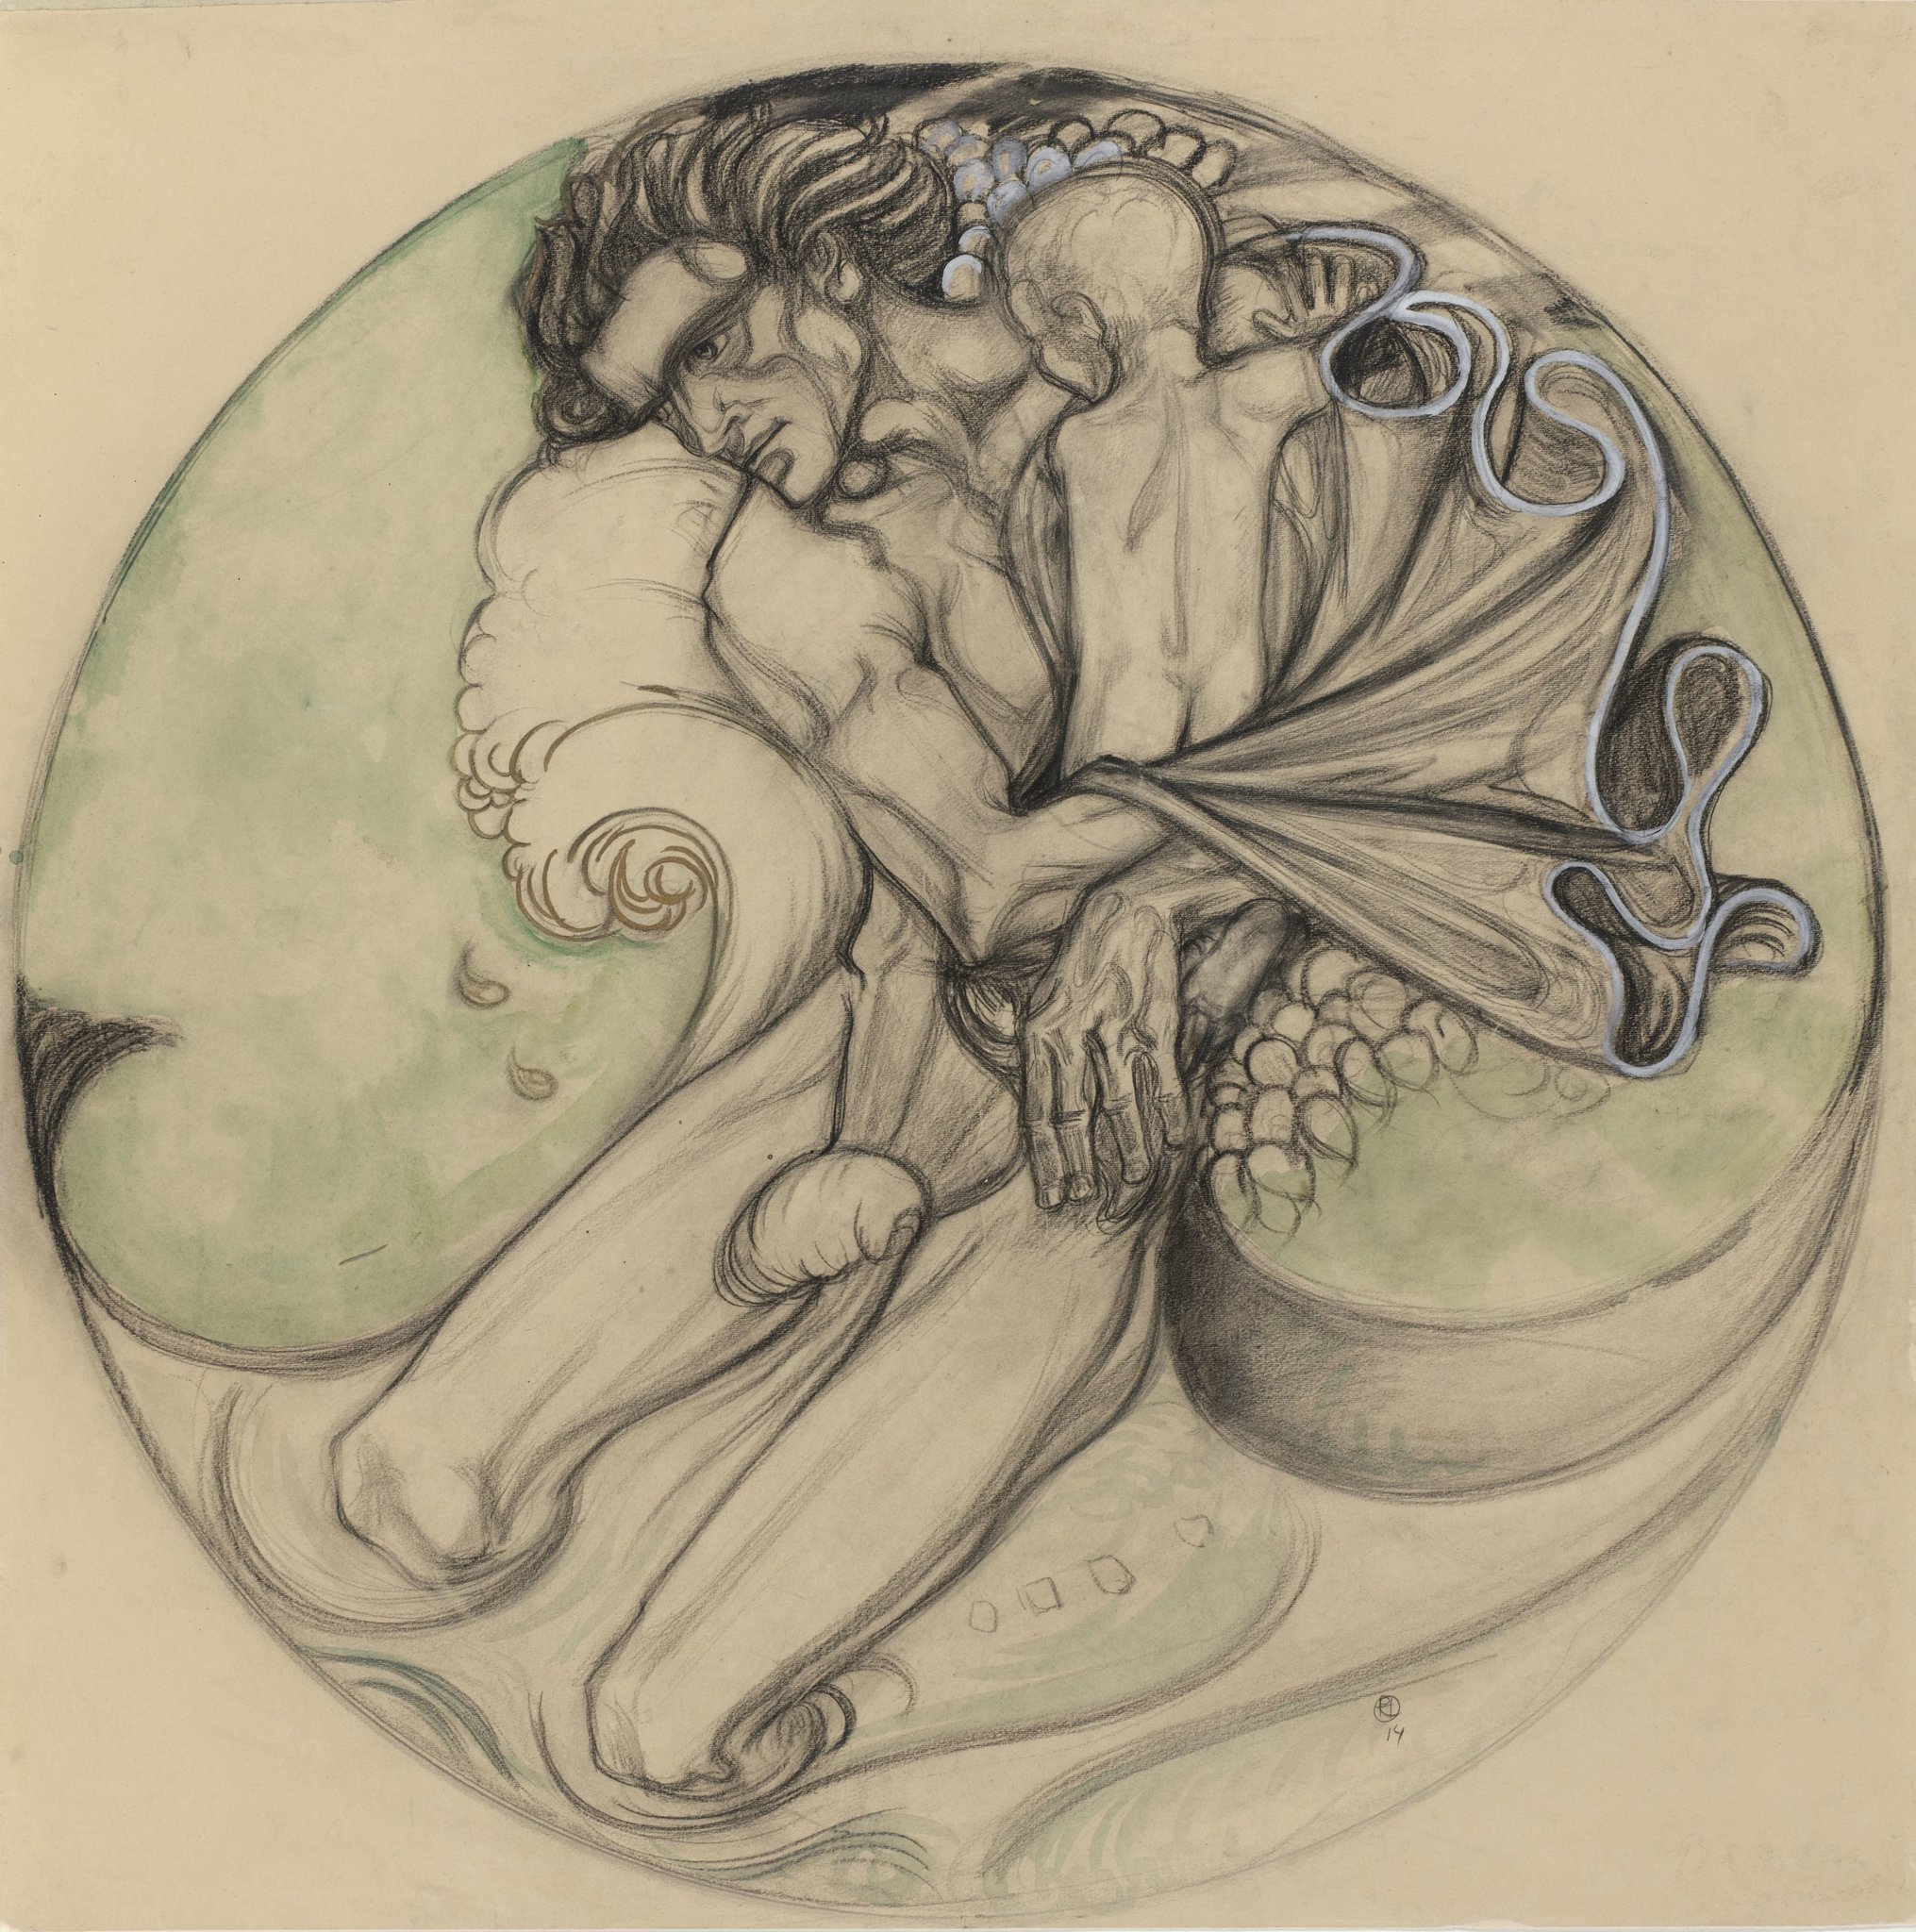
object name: design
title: Christophorus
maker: richard nicolaüs roland holst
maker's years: 1868-1938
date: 1914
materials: chalk, paint, paper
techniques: brush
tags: st. christopher, with the infant christ on his shoulders, wading through the water and carrying his staff (palm-tree); sometimes a hermit stands on the further bank beside a chapel, a lantern in his hand